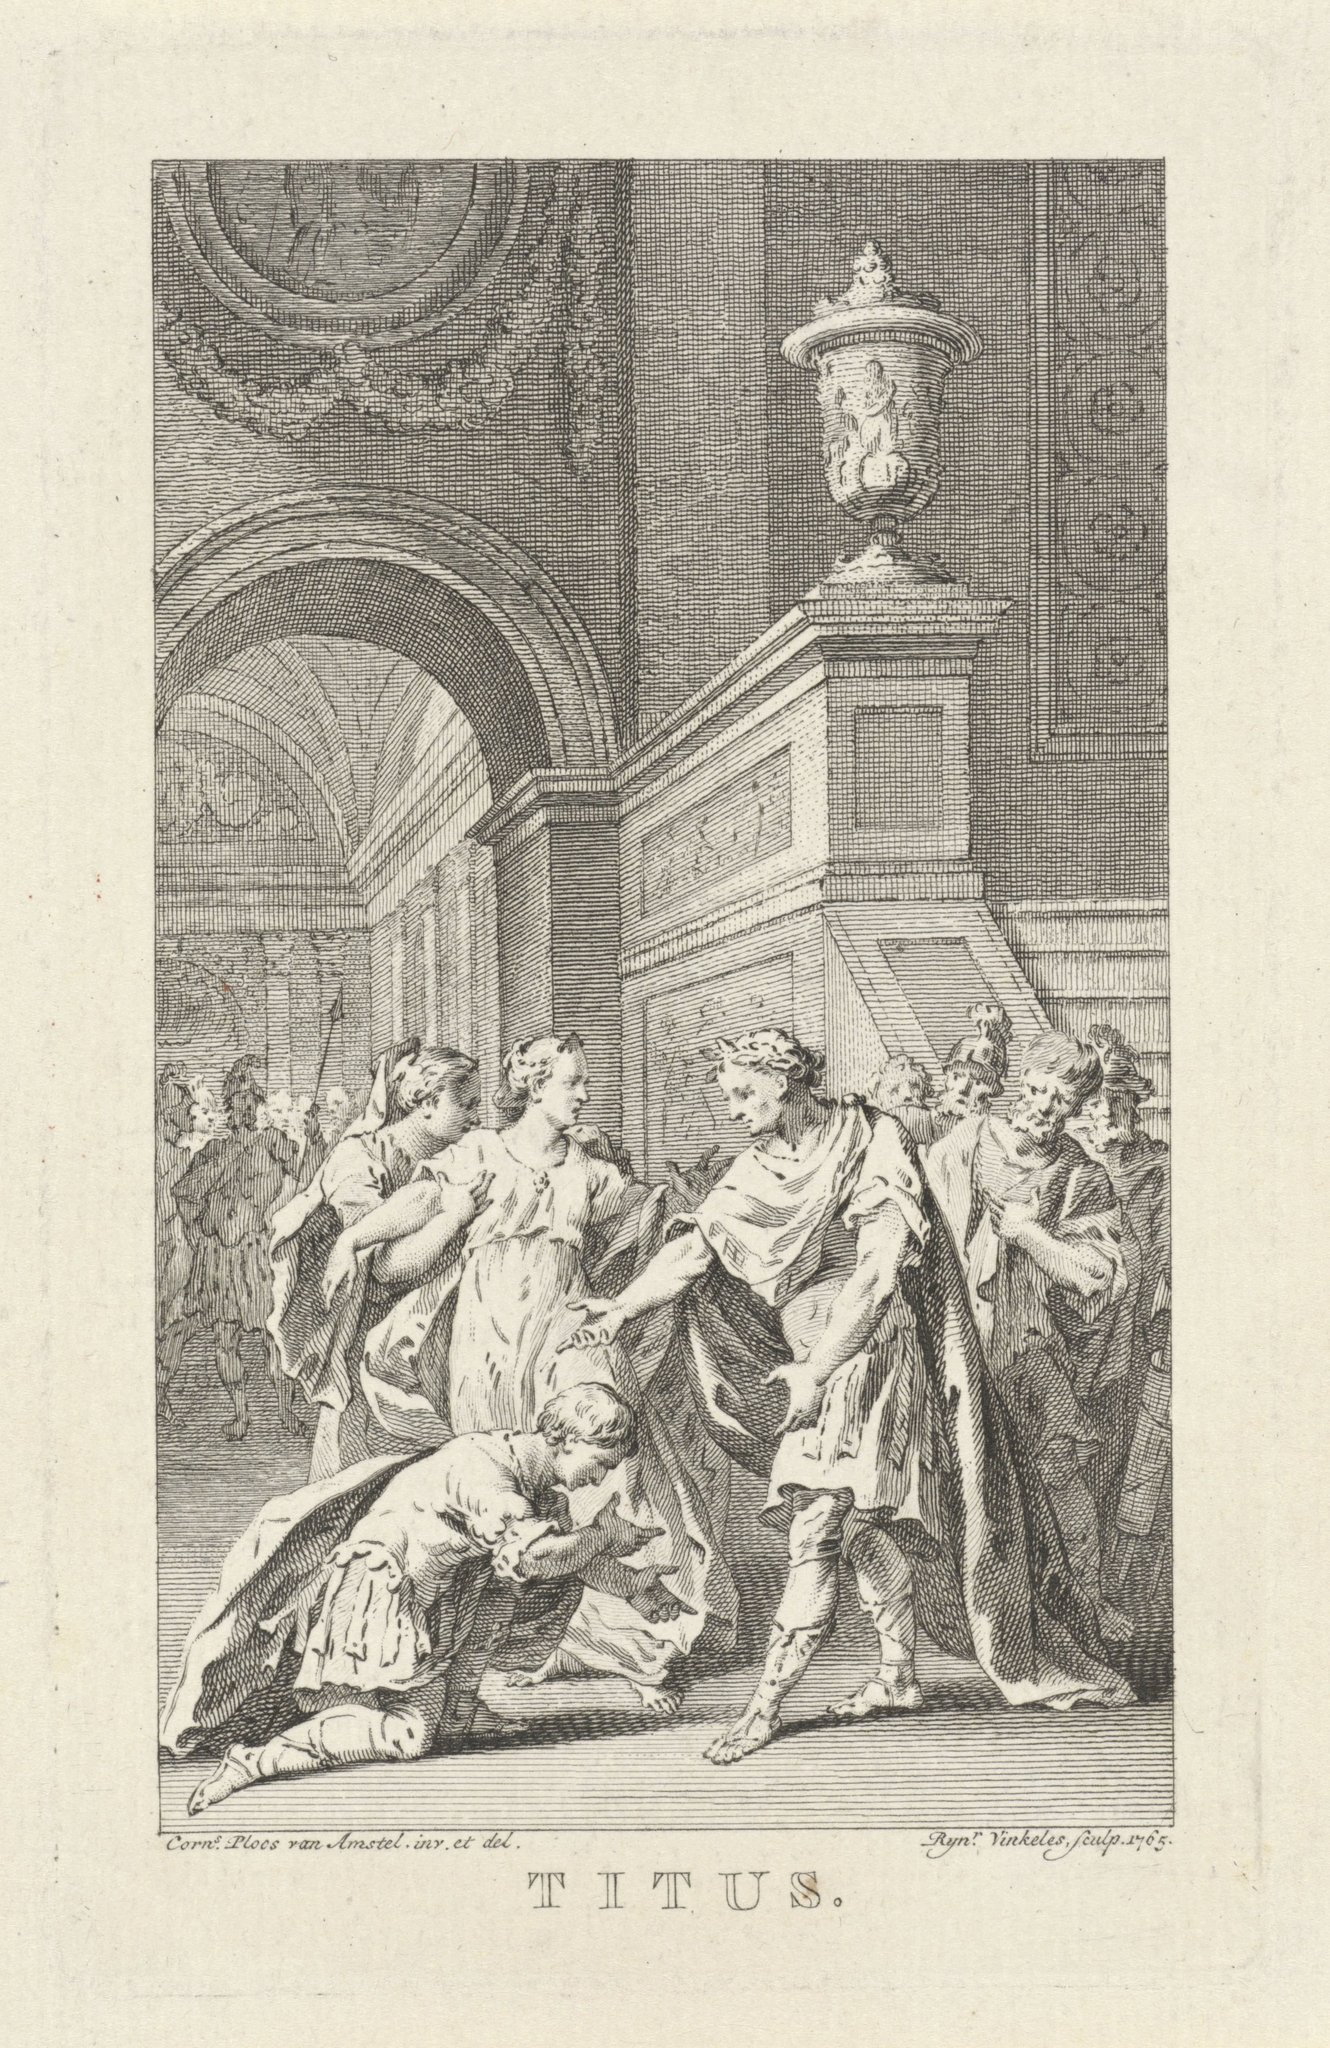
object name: print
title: Man knielt voor een keizer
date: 1765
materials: paper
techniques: engraving, etching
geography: amsterdam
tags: kneeling figure, (story of) the emperor titus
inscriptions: collector's mark: Lugt 240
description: Mogelijk illustratie voor: Nomsz, J. Titus, treurspel. Amsterdam: Izaak Duim, 1765.